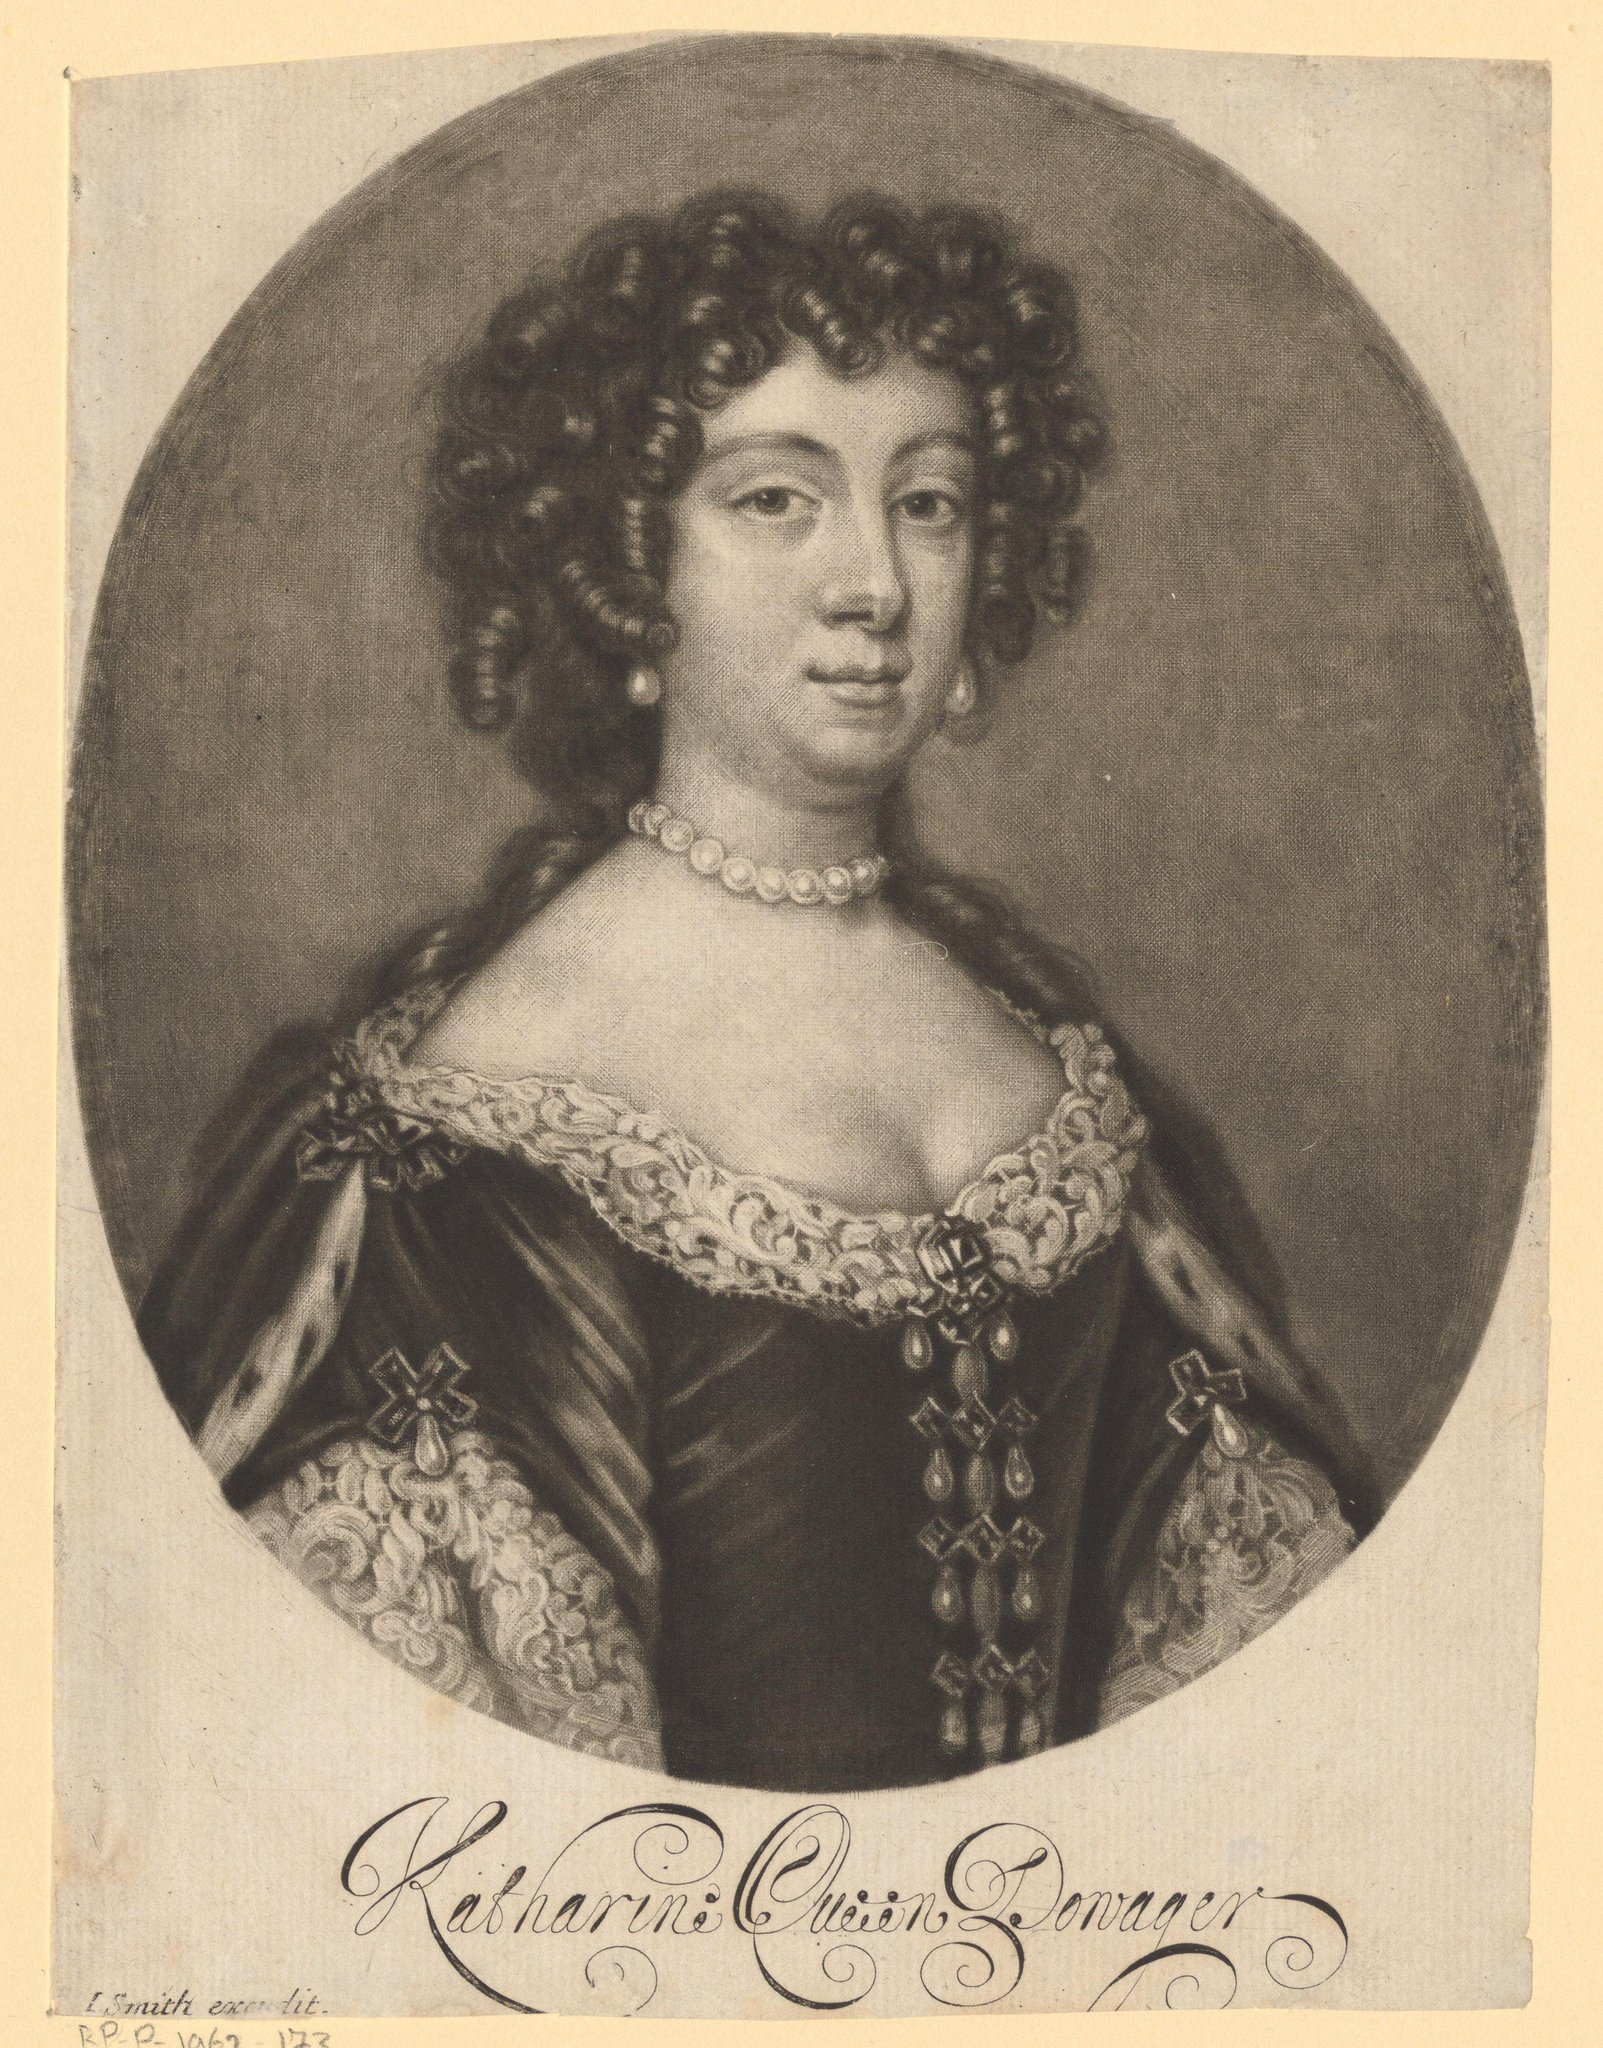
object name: print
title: Portret van Catharina van Bragança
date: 1662-1742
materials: paper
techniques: engraving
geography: london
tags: catharina van bragança, historical persons - bb - woman